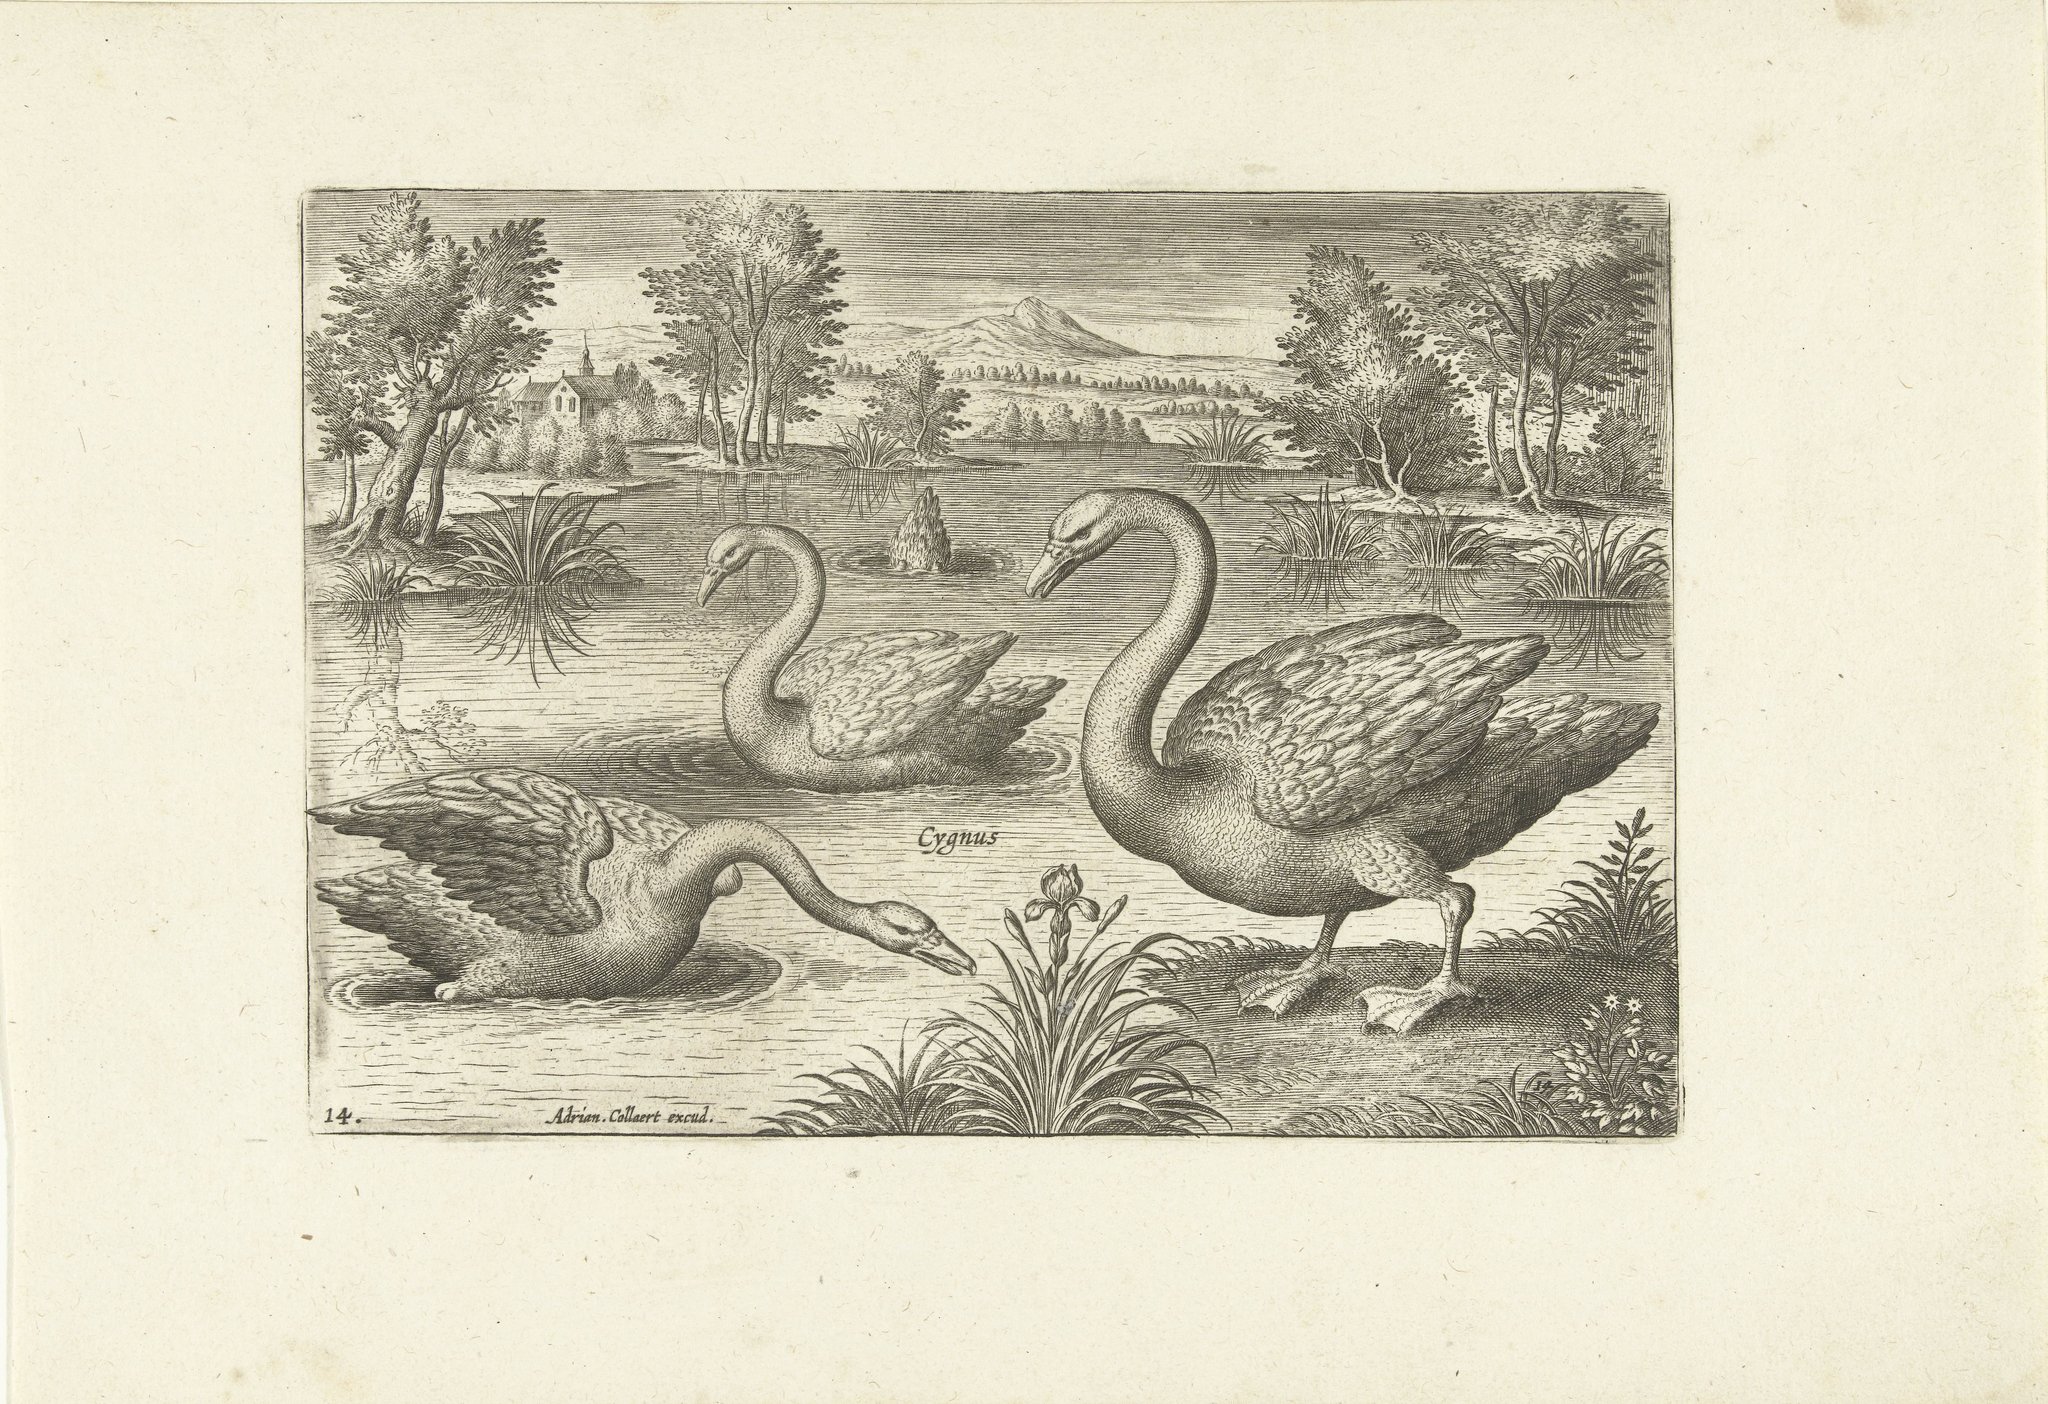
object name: print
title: Avivm vivae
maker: adriaen collaert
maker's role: draughtsman, print maker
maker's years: 1560-1618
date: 1598-1618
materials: paper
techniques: engraving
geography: antwerp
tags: water-birds: swan, pond, pool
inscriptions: collector's mark: Lugt 2228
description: Drie zwanen in een vijver. Op de achtergrond een landschap. De prent maakt deel uit van een serie met vogels als onderwerp.